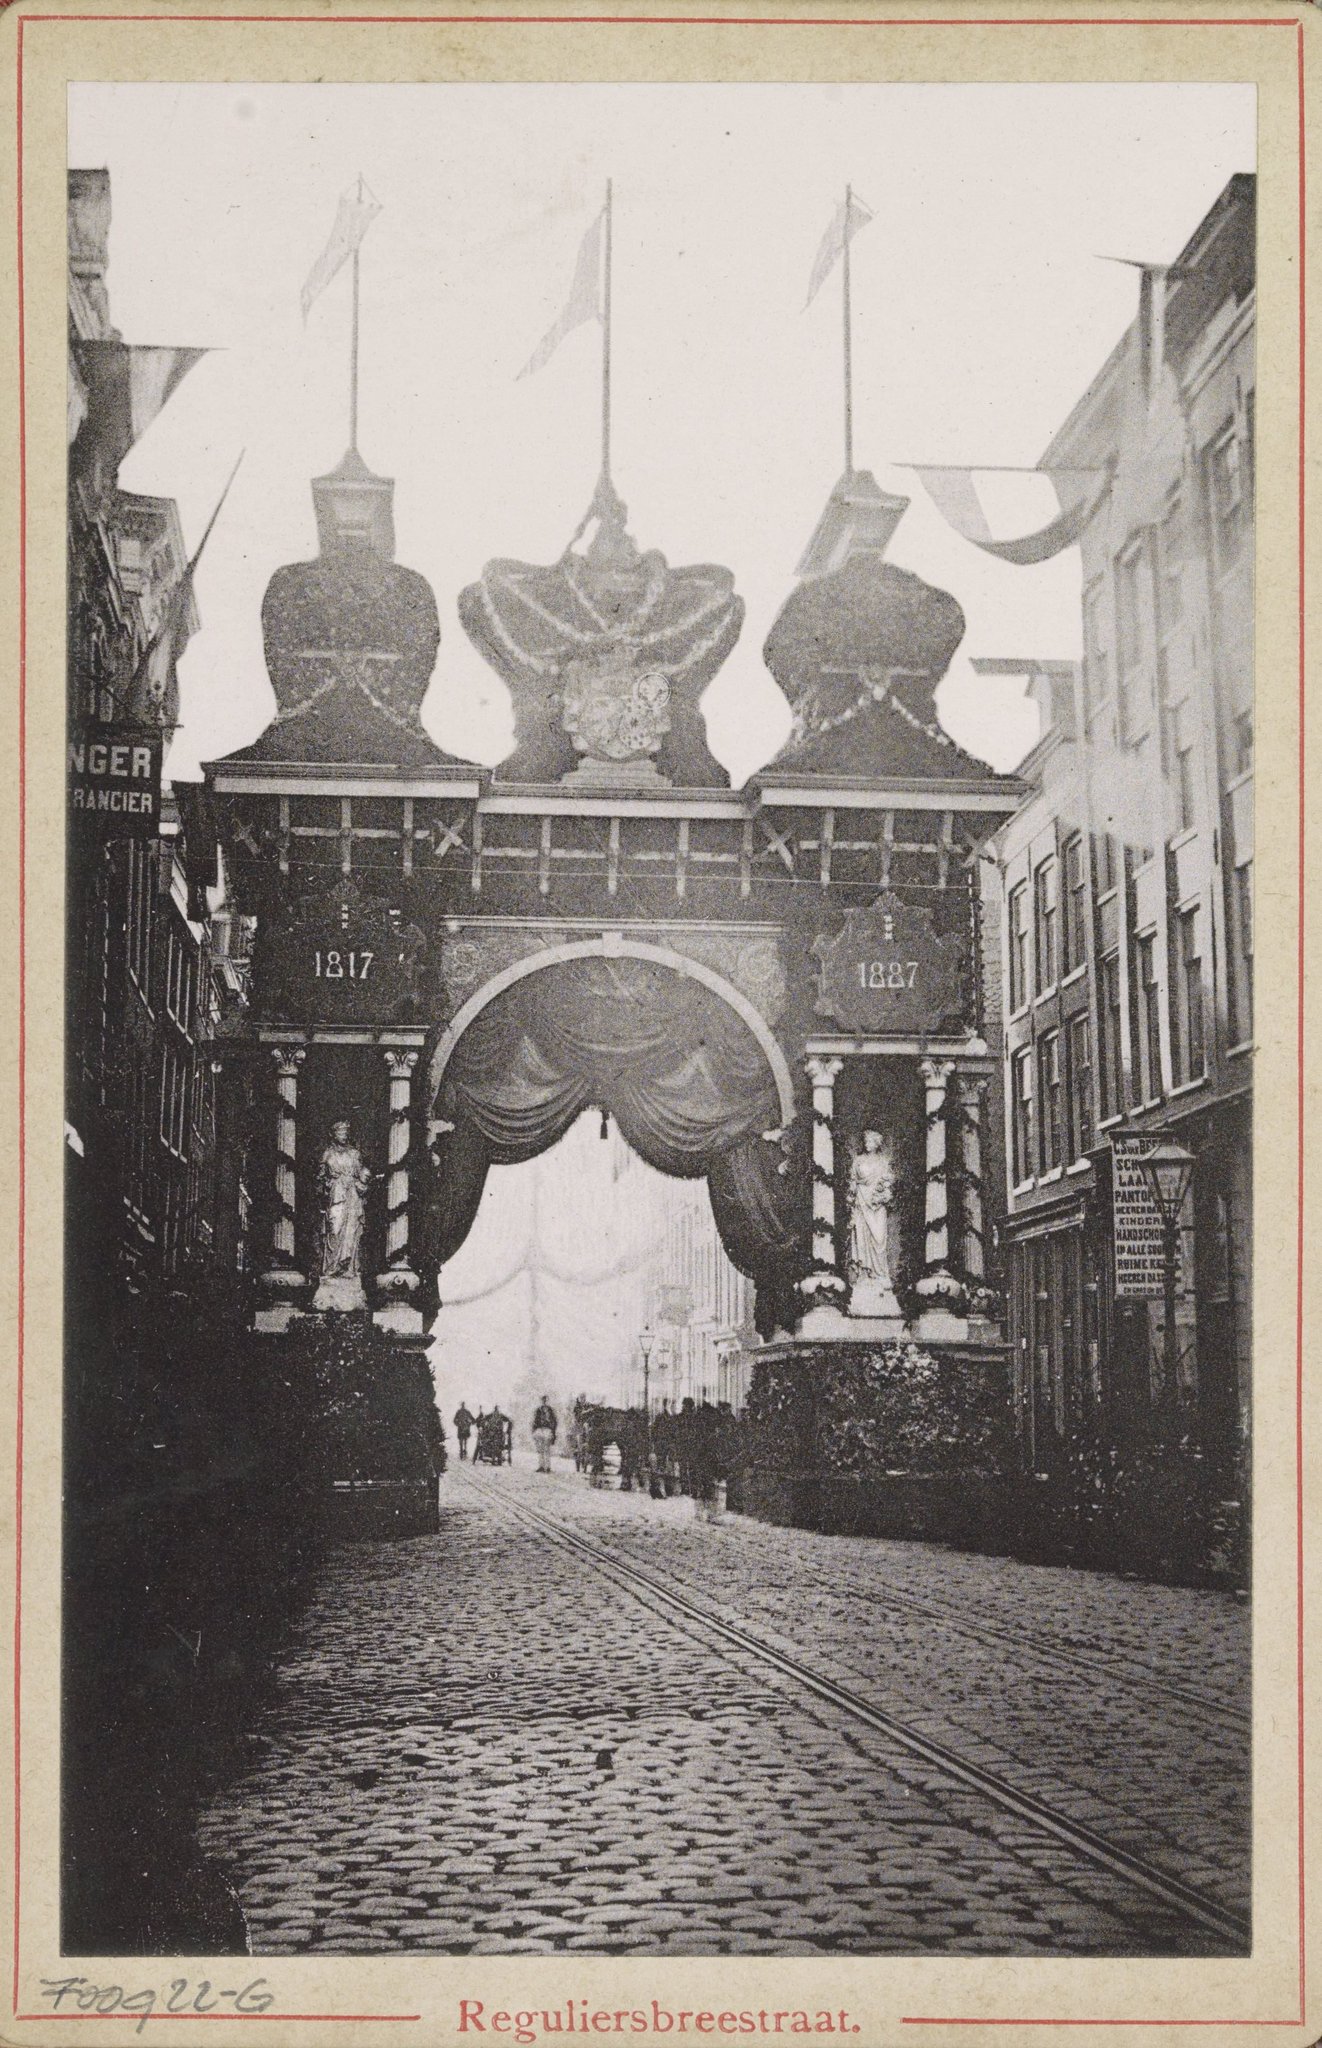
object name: cabinet photograph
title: Reguliersbreestraat.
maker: Anonymous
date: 1804-1887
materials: cardboard, paper, ink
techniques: photograph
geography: amsterdam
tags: gate, entrance, prospect of city, town panorama, silhouette of city, amsterdam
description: Onderdeel van Fotoalbum met opnames van de Aprilfeesten in 1887 te Amsterdam.